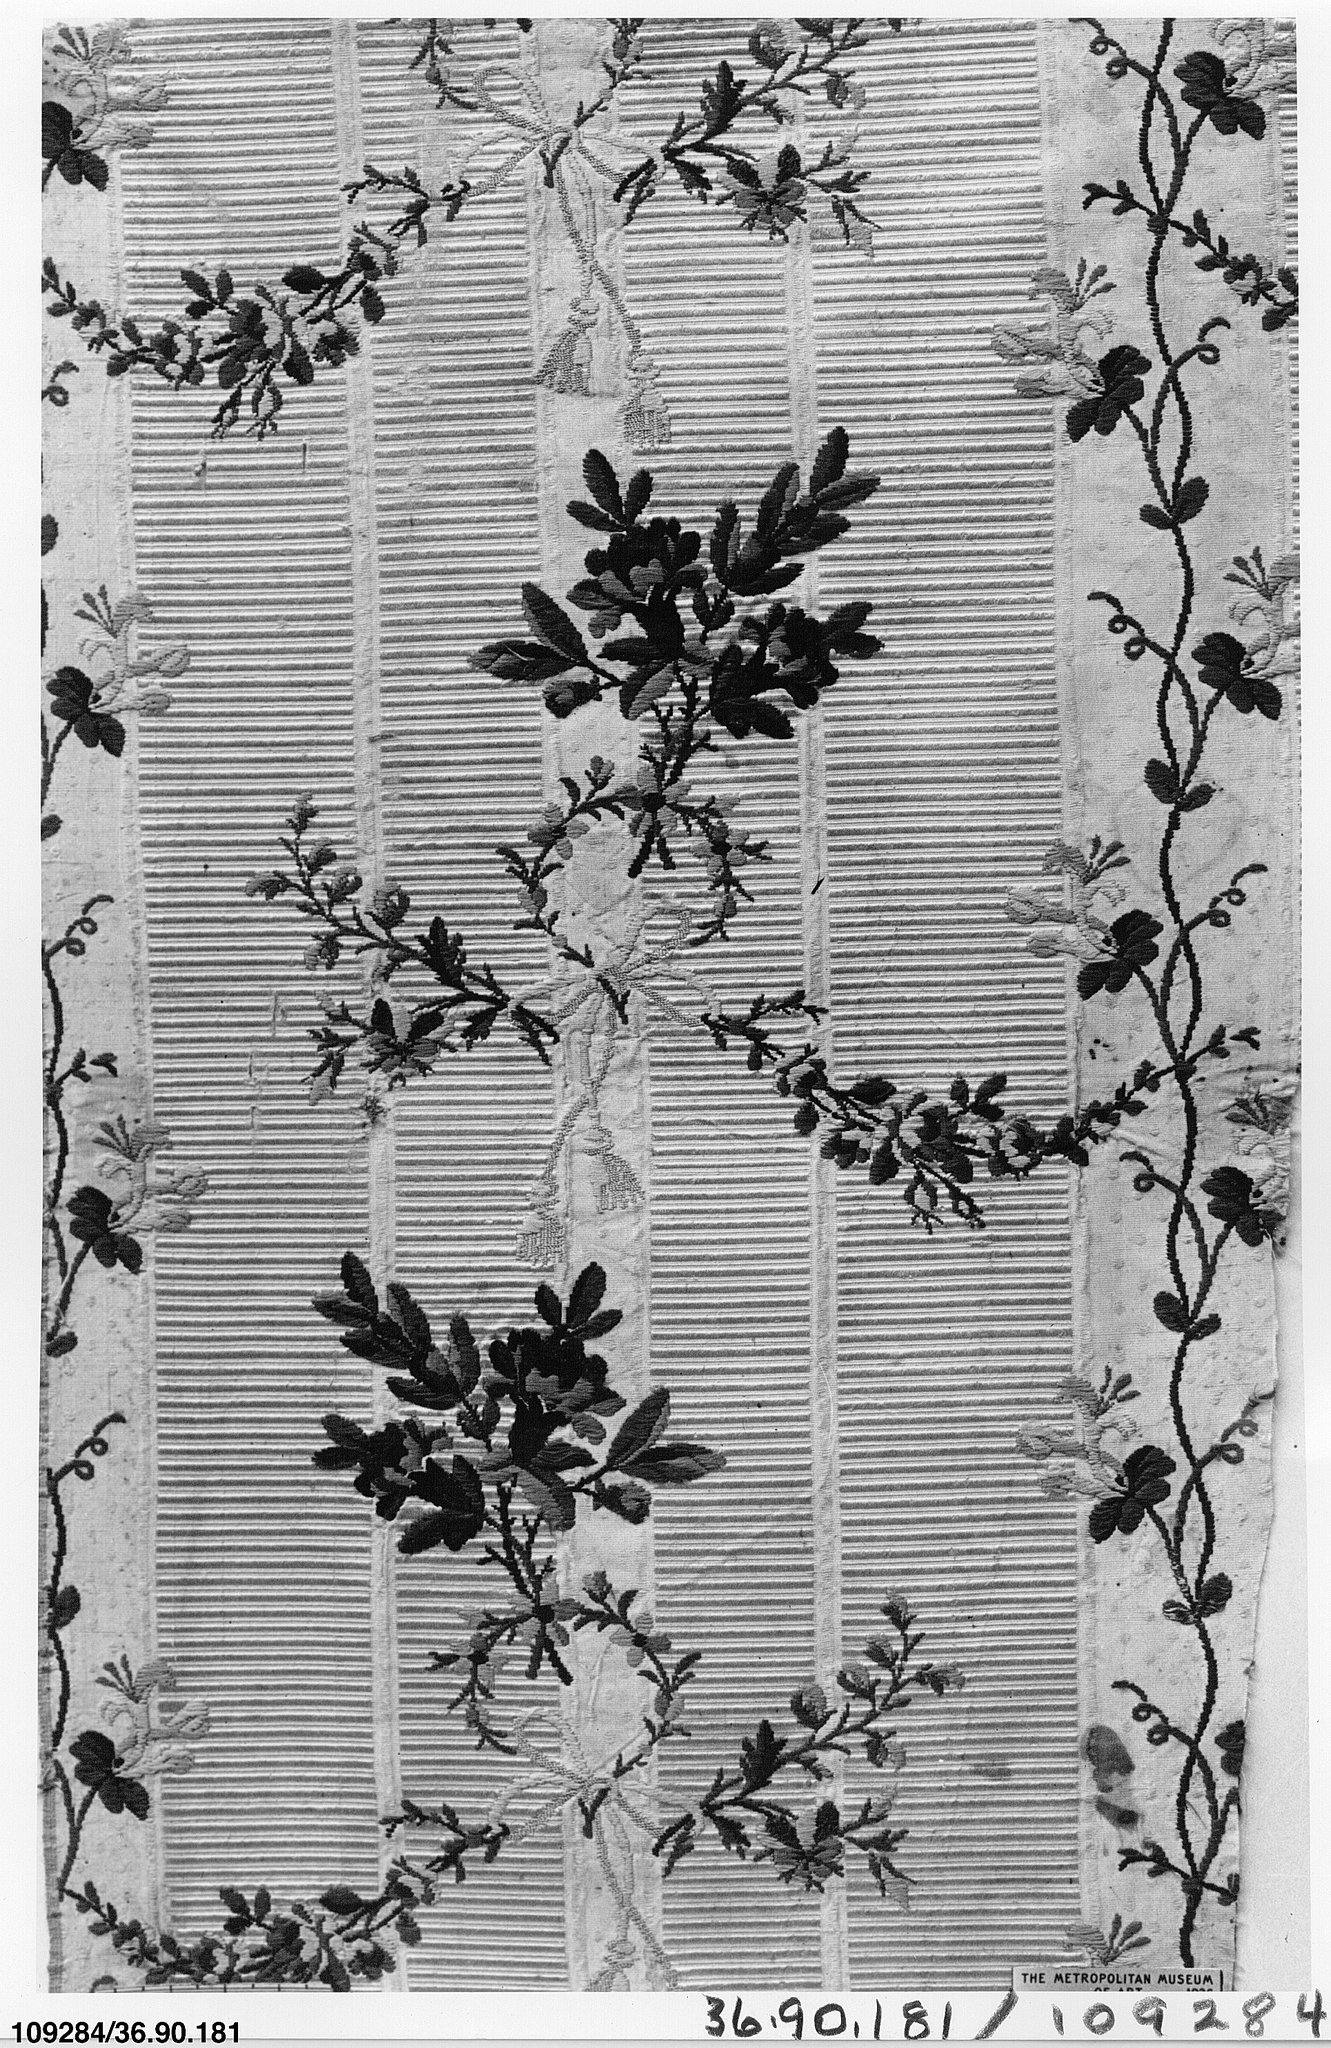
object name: piece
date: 1701-1800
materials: silk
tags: leaves